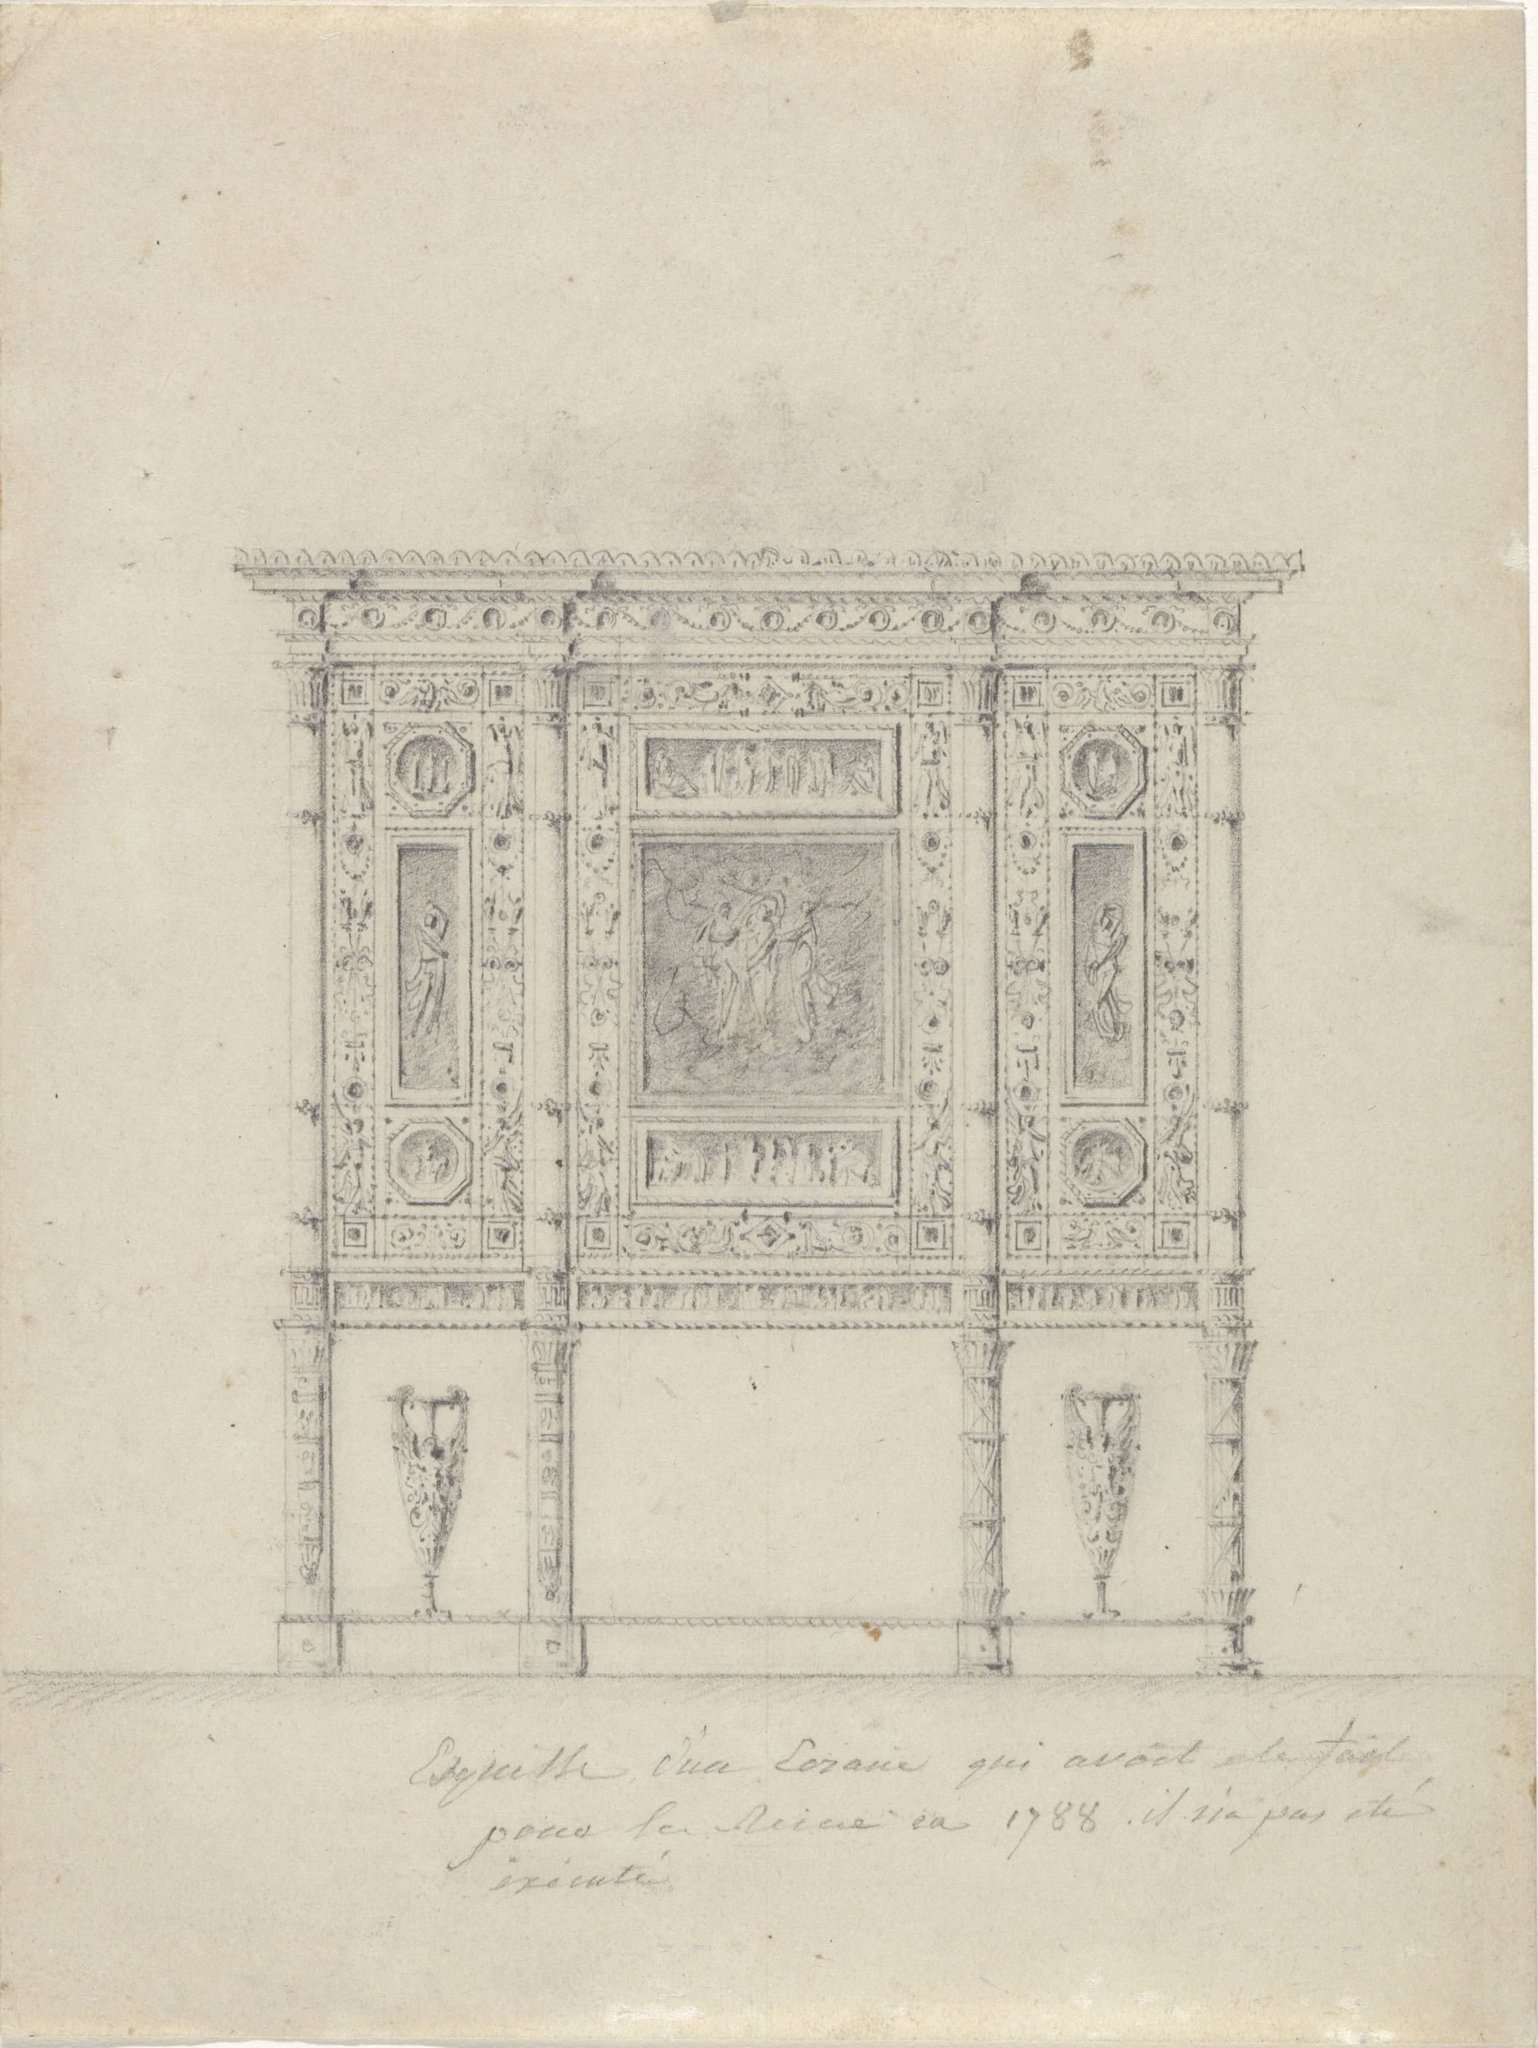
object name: design drawing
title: Ontwerp voor een juwelenkabinet voor een koningin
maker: jean démosthène dugourc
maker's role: draughtsman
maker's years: 1749-1825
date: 1788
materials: graphite, paper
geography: paris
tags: decorative furniture, jewel-box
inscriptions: inscription: ‘Esquisse d'un Ecrain qui avait été fait / pour la Reine en 1788. il n'a pas été / exécuté’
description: Oorspronkelijk werd het ontwerp bekroond door een centraal element, vermoedelijk een adelaar, geflankeerd door twee kleinere elementen, vermoedelijk vazen; deze zijn uitgevlakt, wellicht al tijdens het vervaardigen van de tekening.